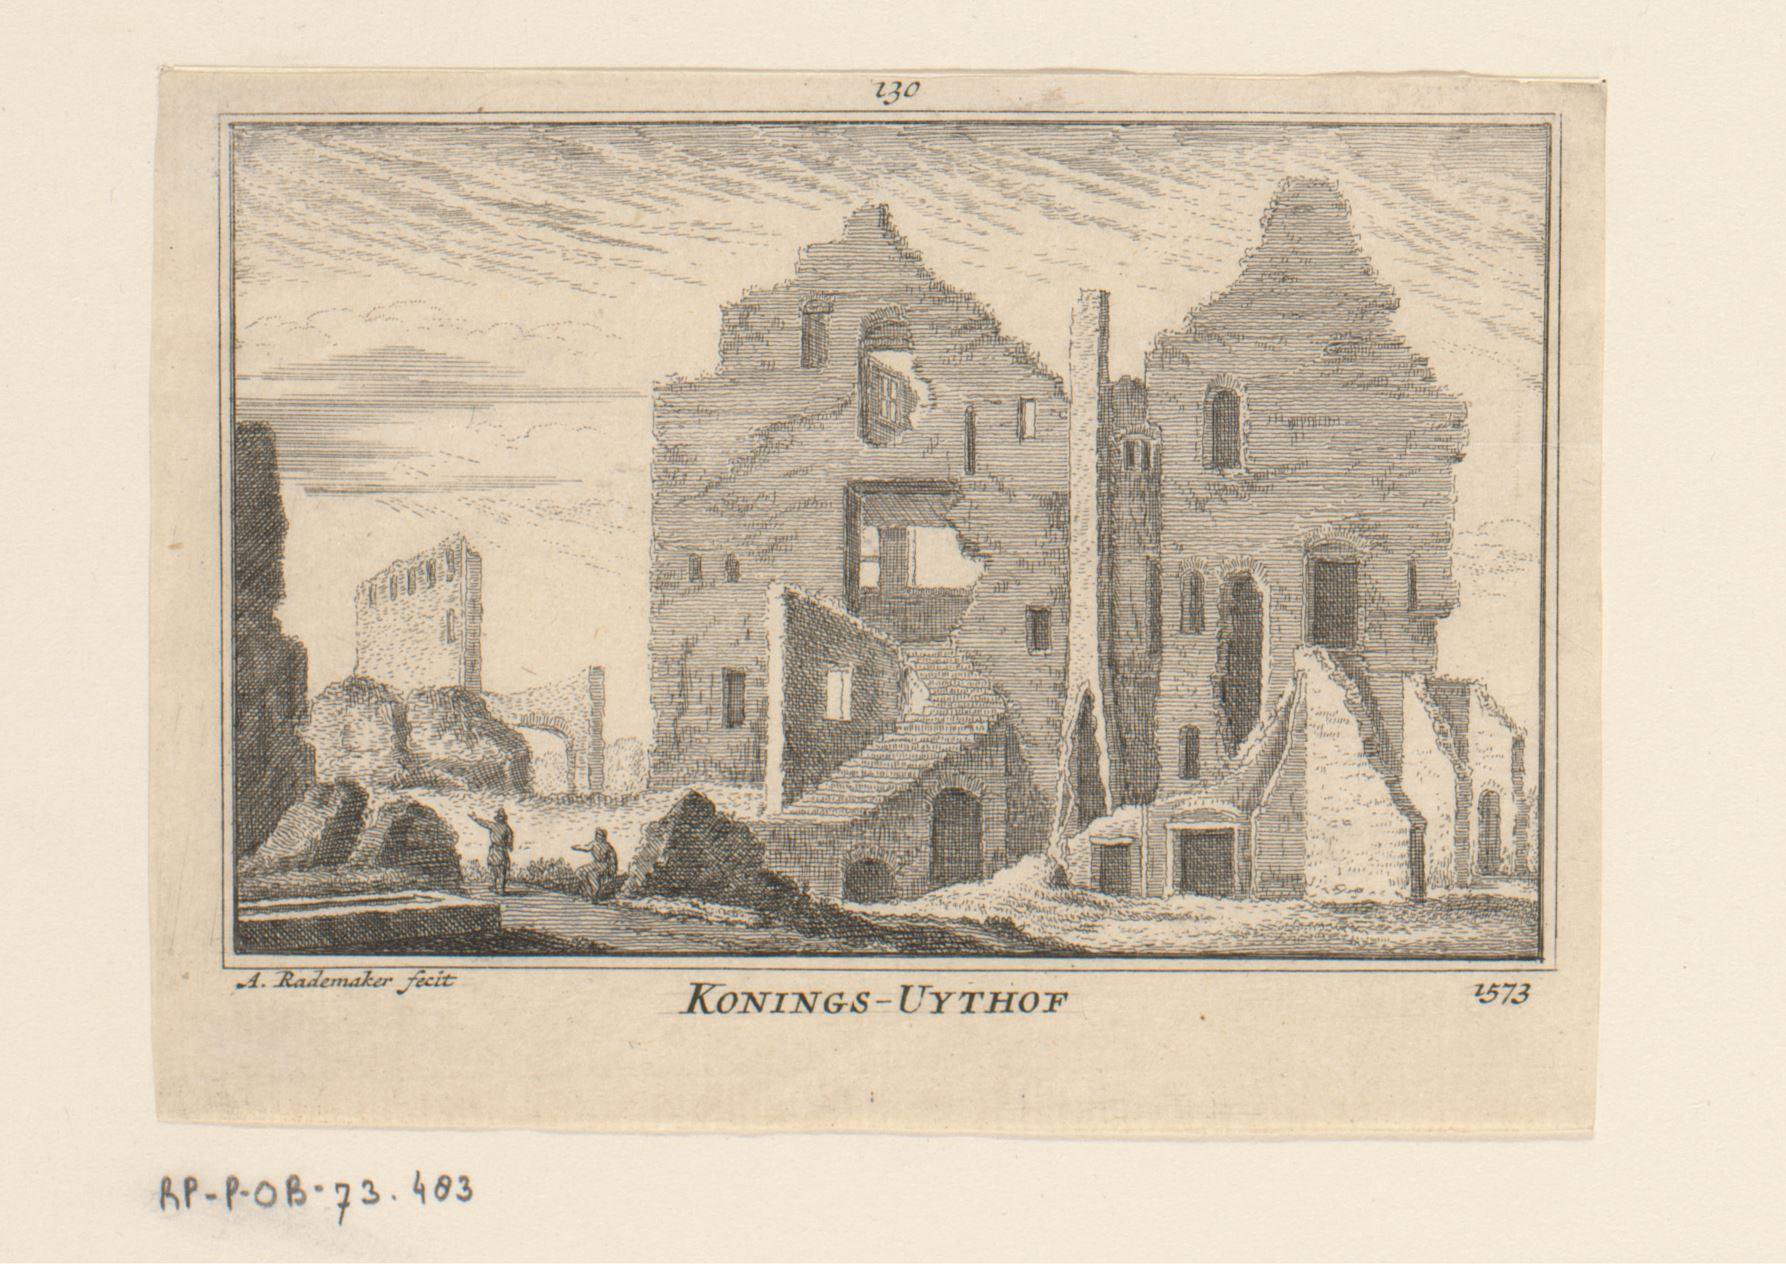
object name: book illustration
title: Gezicht op de ruïne van het Konings Uithof, 1573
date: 1727-1733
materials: paper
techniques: etching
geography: amsterdam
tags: ruin of church, monastery, etc., staircase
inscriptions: collector's mark: Lugt 2228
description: Illustratie uit: Abraham Rademaker, Matthaeus Brouërius van Niedek, Isaac Le Long, Kabinet van Nederlandsche en Kleefsche outheden en (...) voorname stads- en landgebouwen, Willem Barents en Antoni Schoonenburg: Amsterdam, 1727-1733, ill. nr. 130.